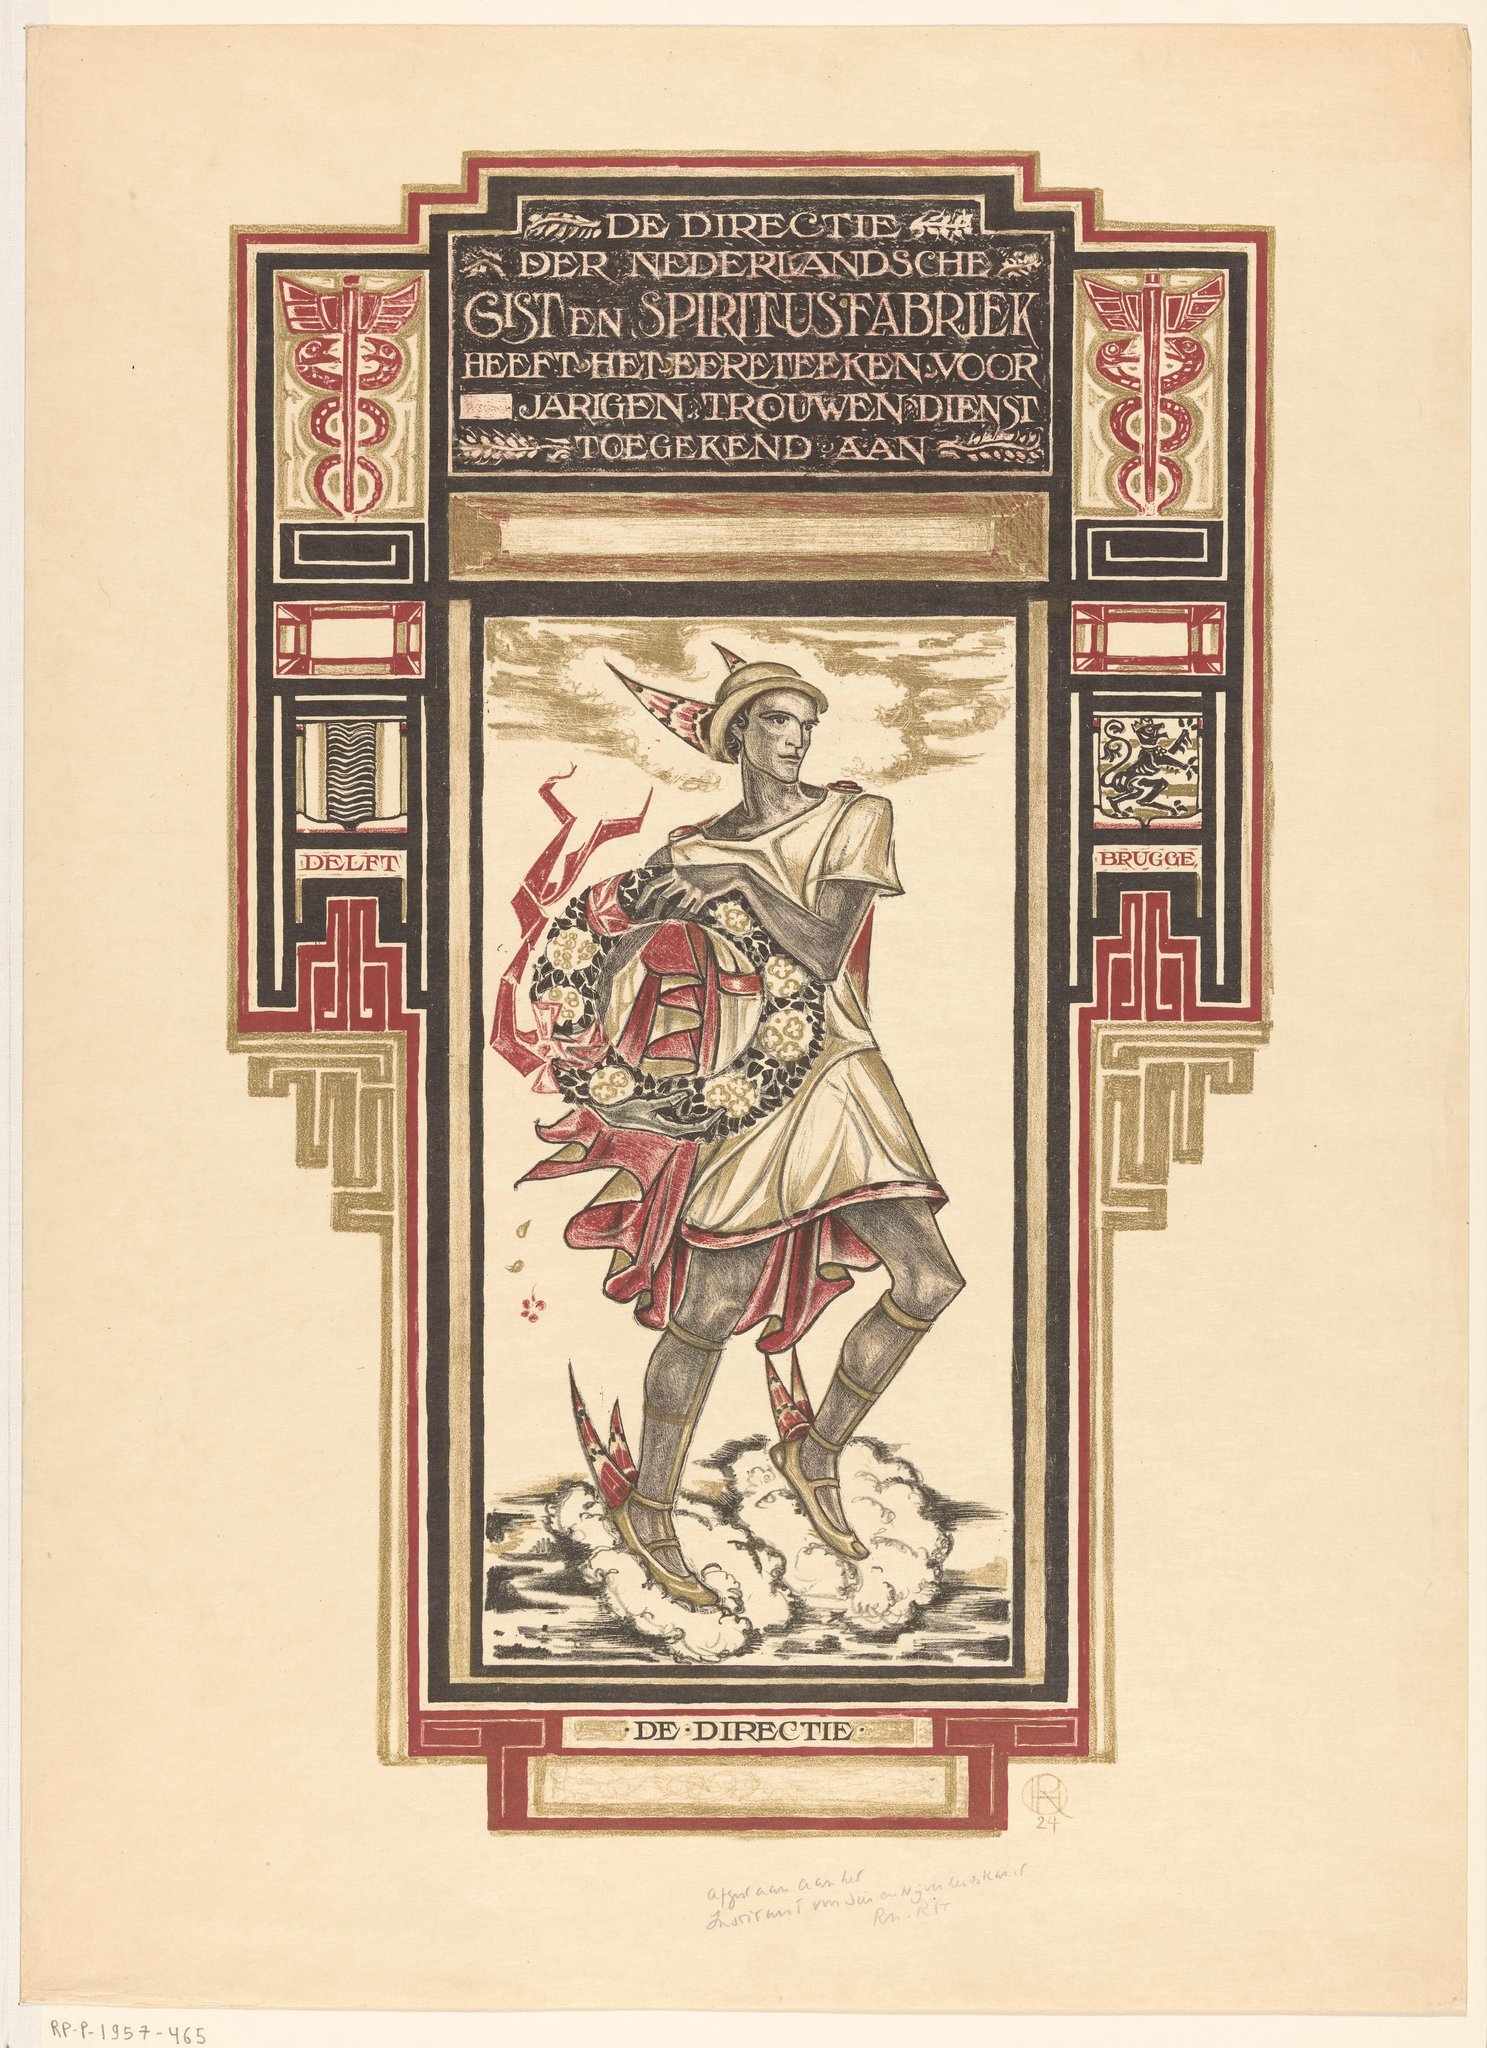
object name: design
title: Ontwerp voor: Diploma voor trouwe dienst bij de Nederlandsche Gist- en Spiritusfabriek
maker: richard nicolaüs roland holst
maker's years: 1868-1938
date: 1924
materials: paper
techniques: lithograph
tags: garland, wreath, (story of) mercury (hermes)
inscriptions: collector's mark: Lugt 2228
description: Hermes, herkenbaar aan zijn gevleugelde sandalen en petasus (hoed), die een bloemenkrans vasthoudt. Om het geheel een kader met links en rechts een zogenaamde caduceus, een door twee slangen omwonden staf, en de stadswapens van Delft en Brugge. Bovenaan de tekst 'De directie der Nederlandsche Gist en Spiritusfabriek heeft het eereteeken voor [...] jarigen trouwen dienst toegekend aan [...]'.